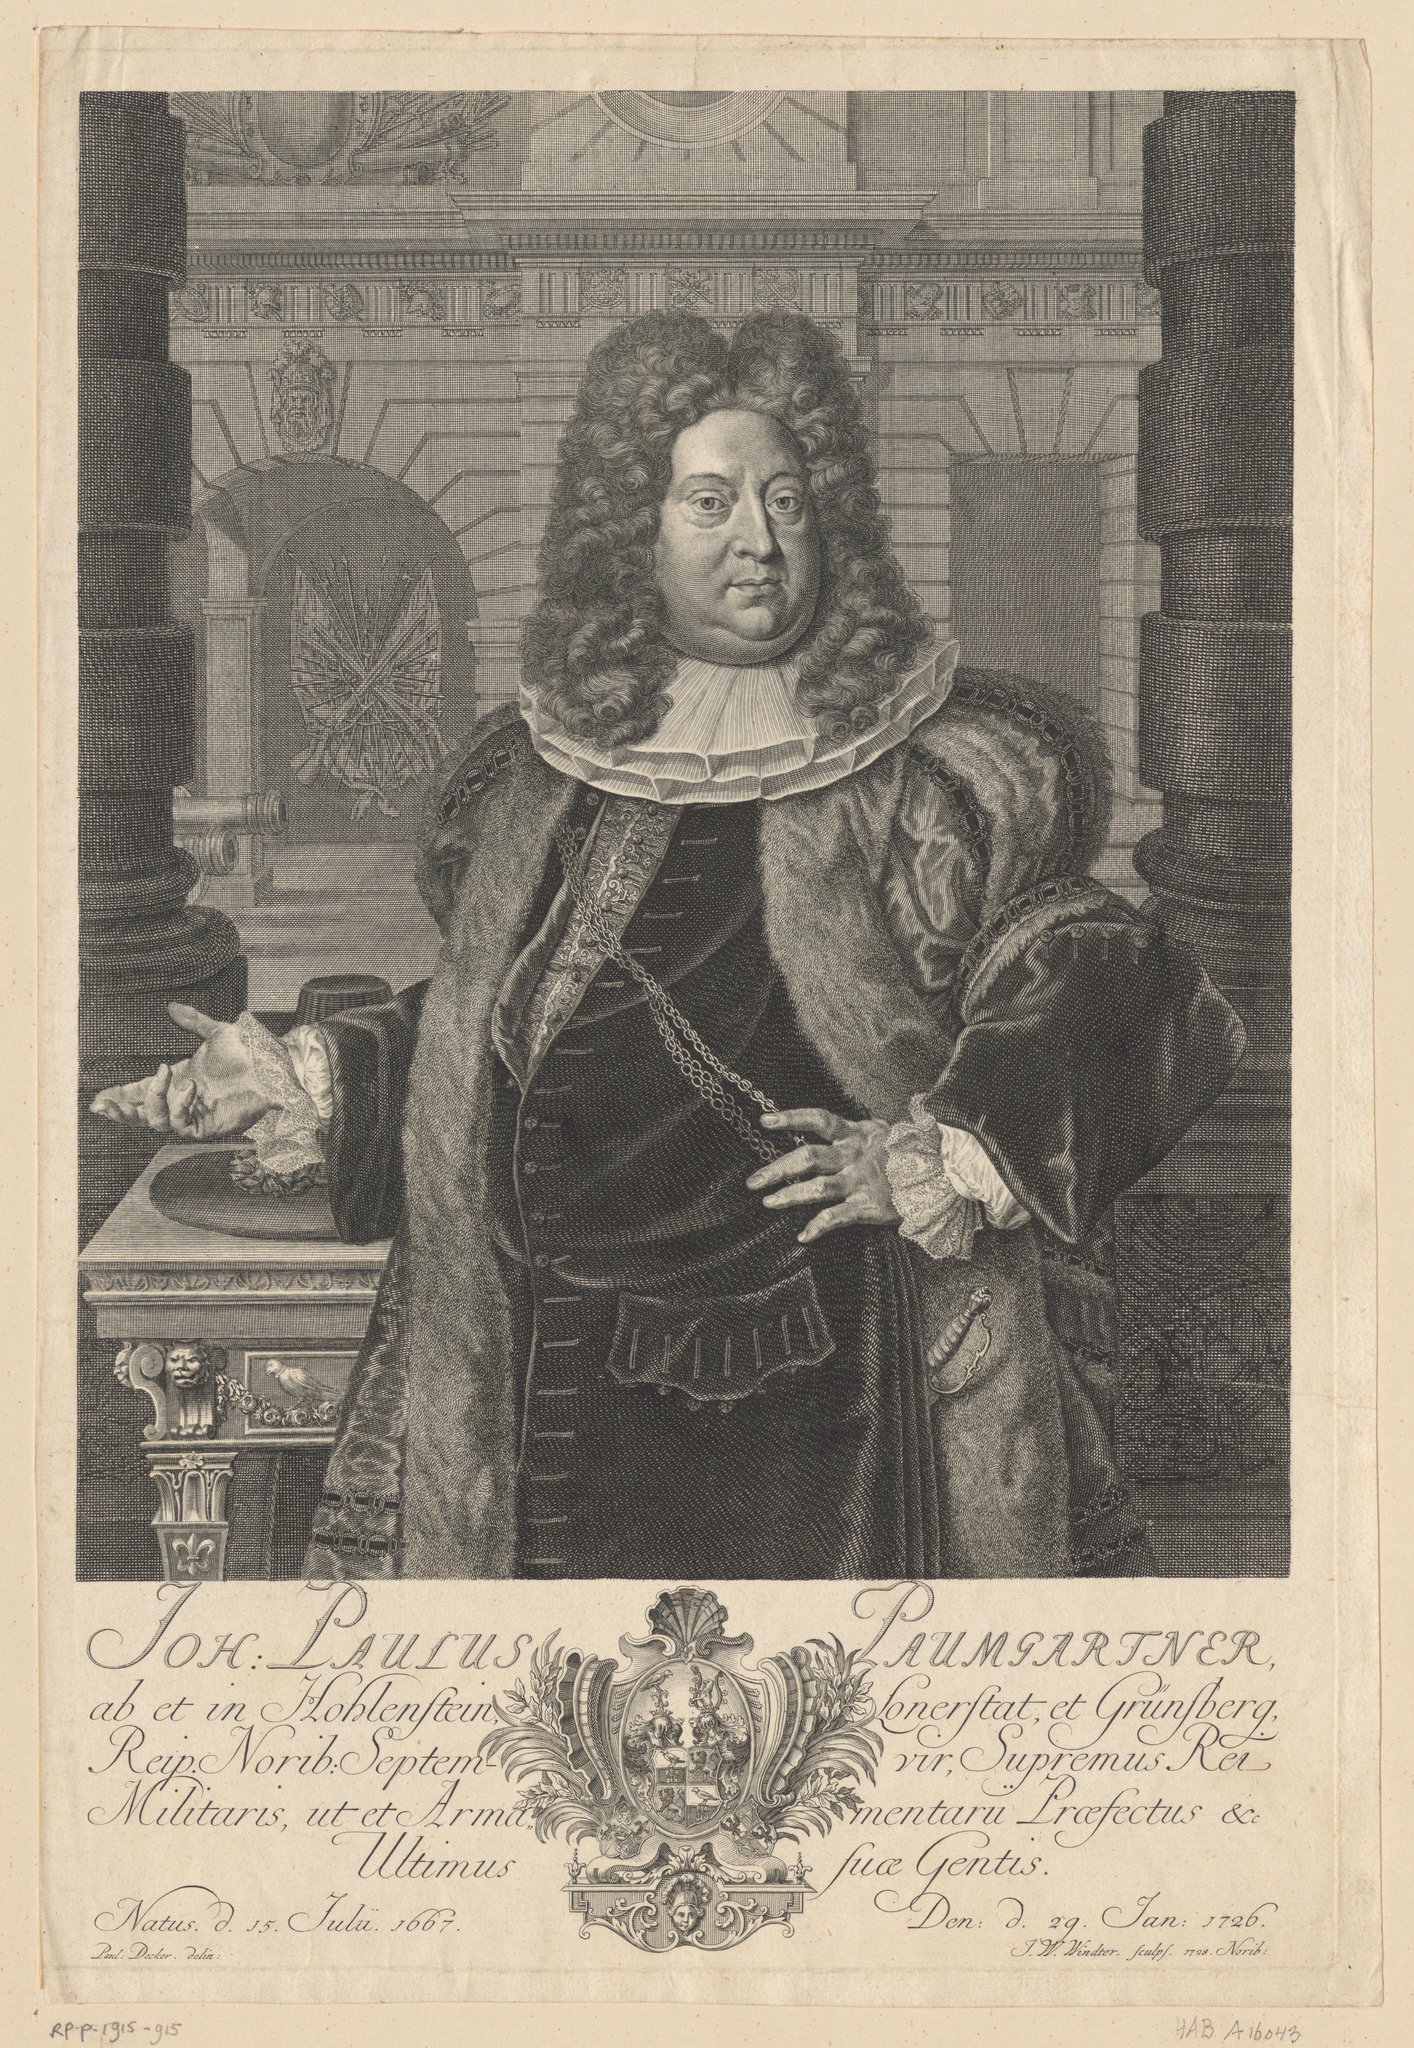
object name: print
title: Portret van Johann Paul Paumgartner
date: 1728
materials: paper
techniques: engraving, etching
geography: nuremberg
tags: adult man, historical persons, armorial bearing, heraldry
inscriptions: collector's mark: Lugt 2228